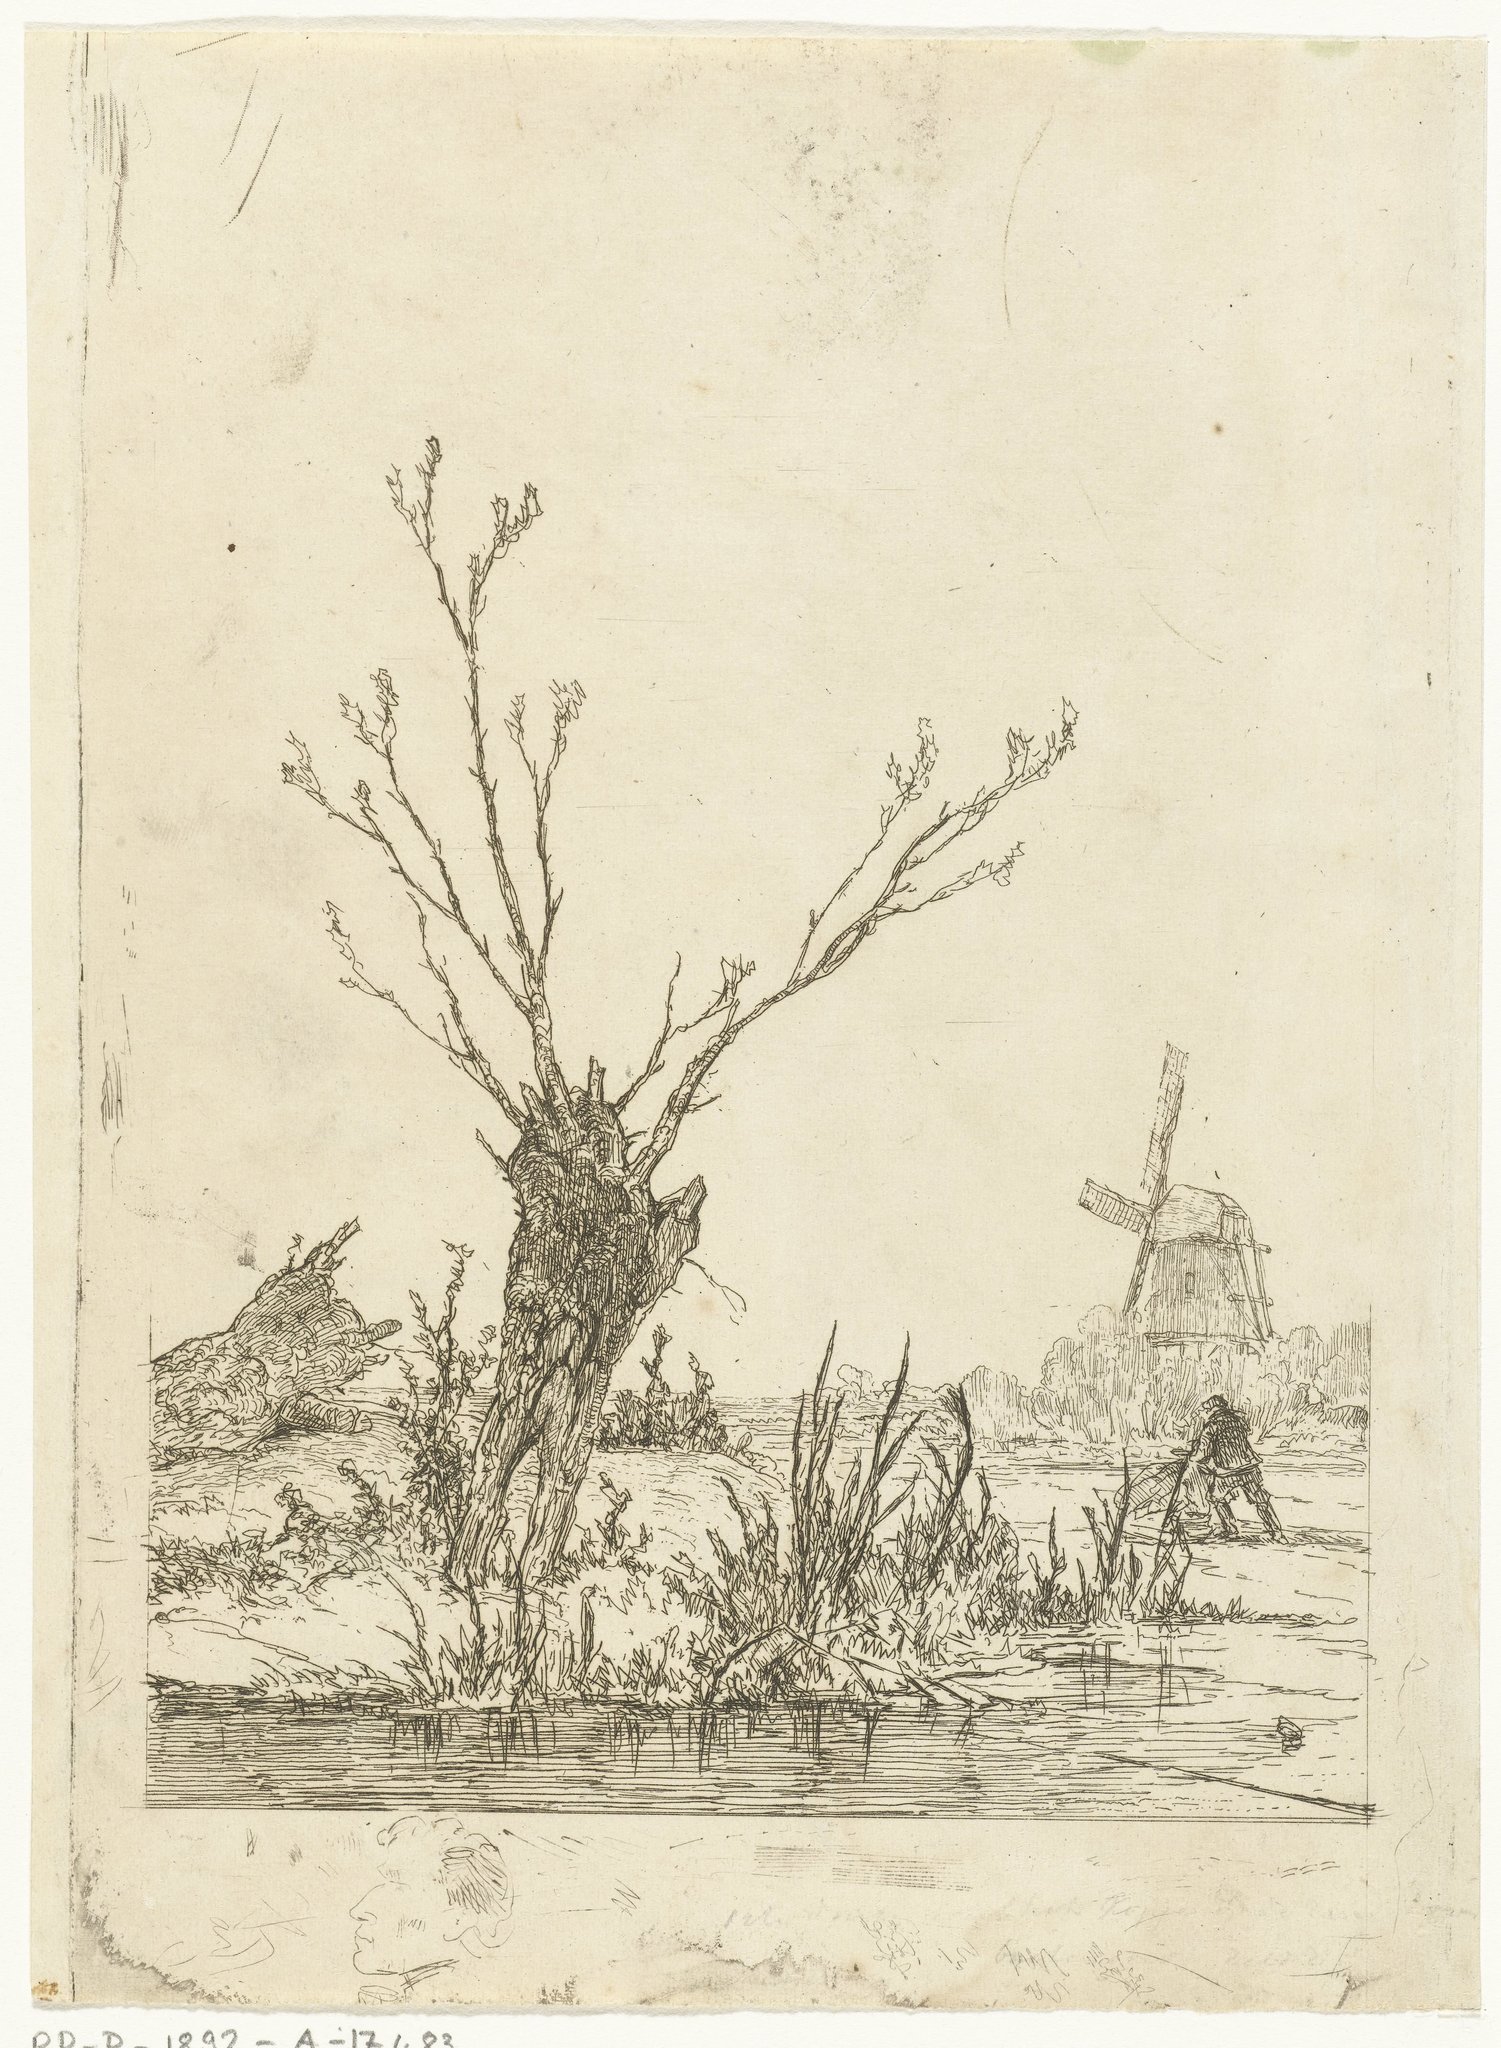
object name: print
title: Winterlandschap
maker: david bles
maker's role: draughtsman, painter, print maker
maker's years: 1821-1899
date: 1834-1892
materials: paper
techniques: etching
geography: the hague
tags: trees: willow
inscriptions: collector's mark: Lugt 2228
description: Links op de voorgrond een bladerloze oude knotwilg aan de oever van een bevroren water. Op de achtergrond een windmolen. In de ondermarge een remarque met een kop van een man, naar links.